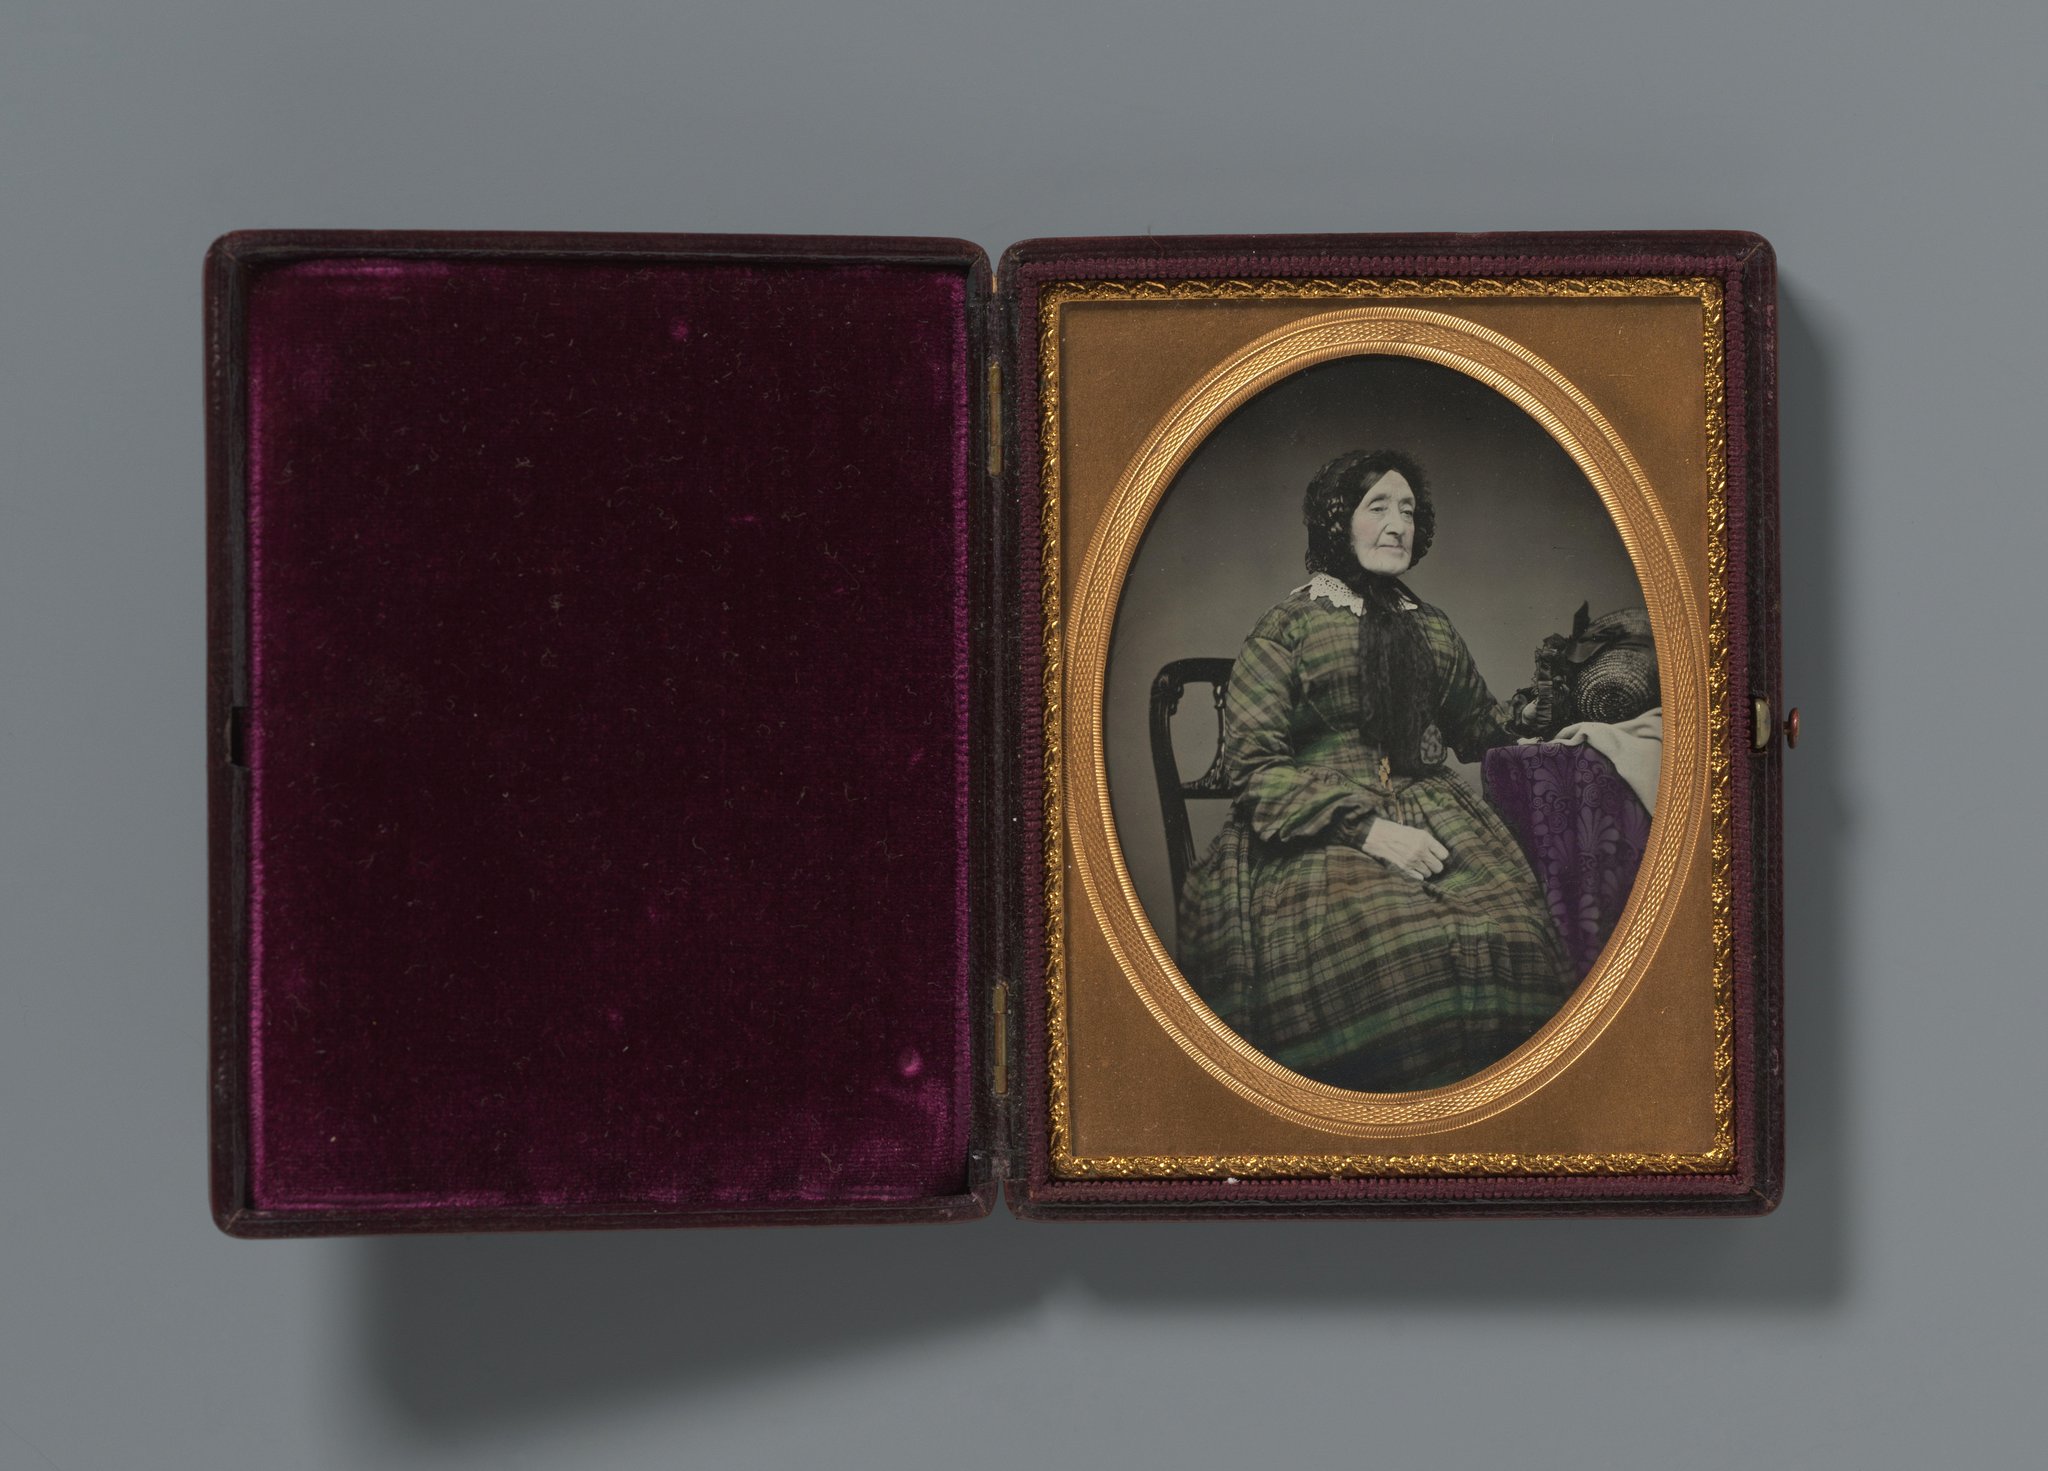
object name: photograph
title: Portret van een onbekende vrouw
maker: Anonymous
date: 1855-1870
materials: glass, leather, metal, velvet, wood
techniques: ambrotype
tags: historical persons - bb - woman